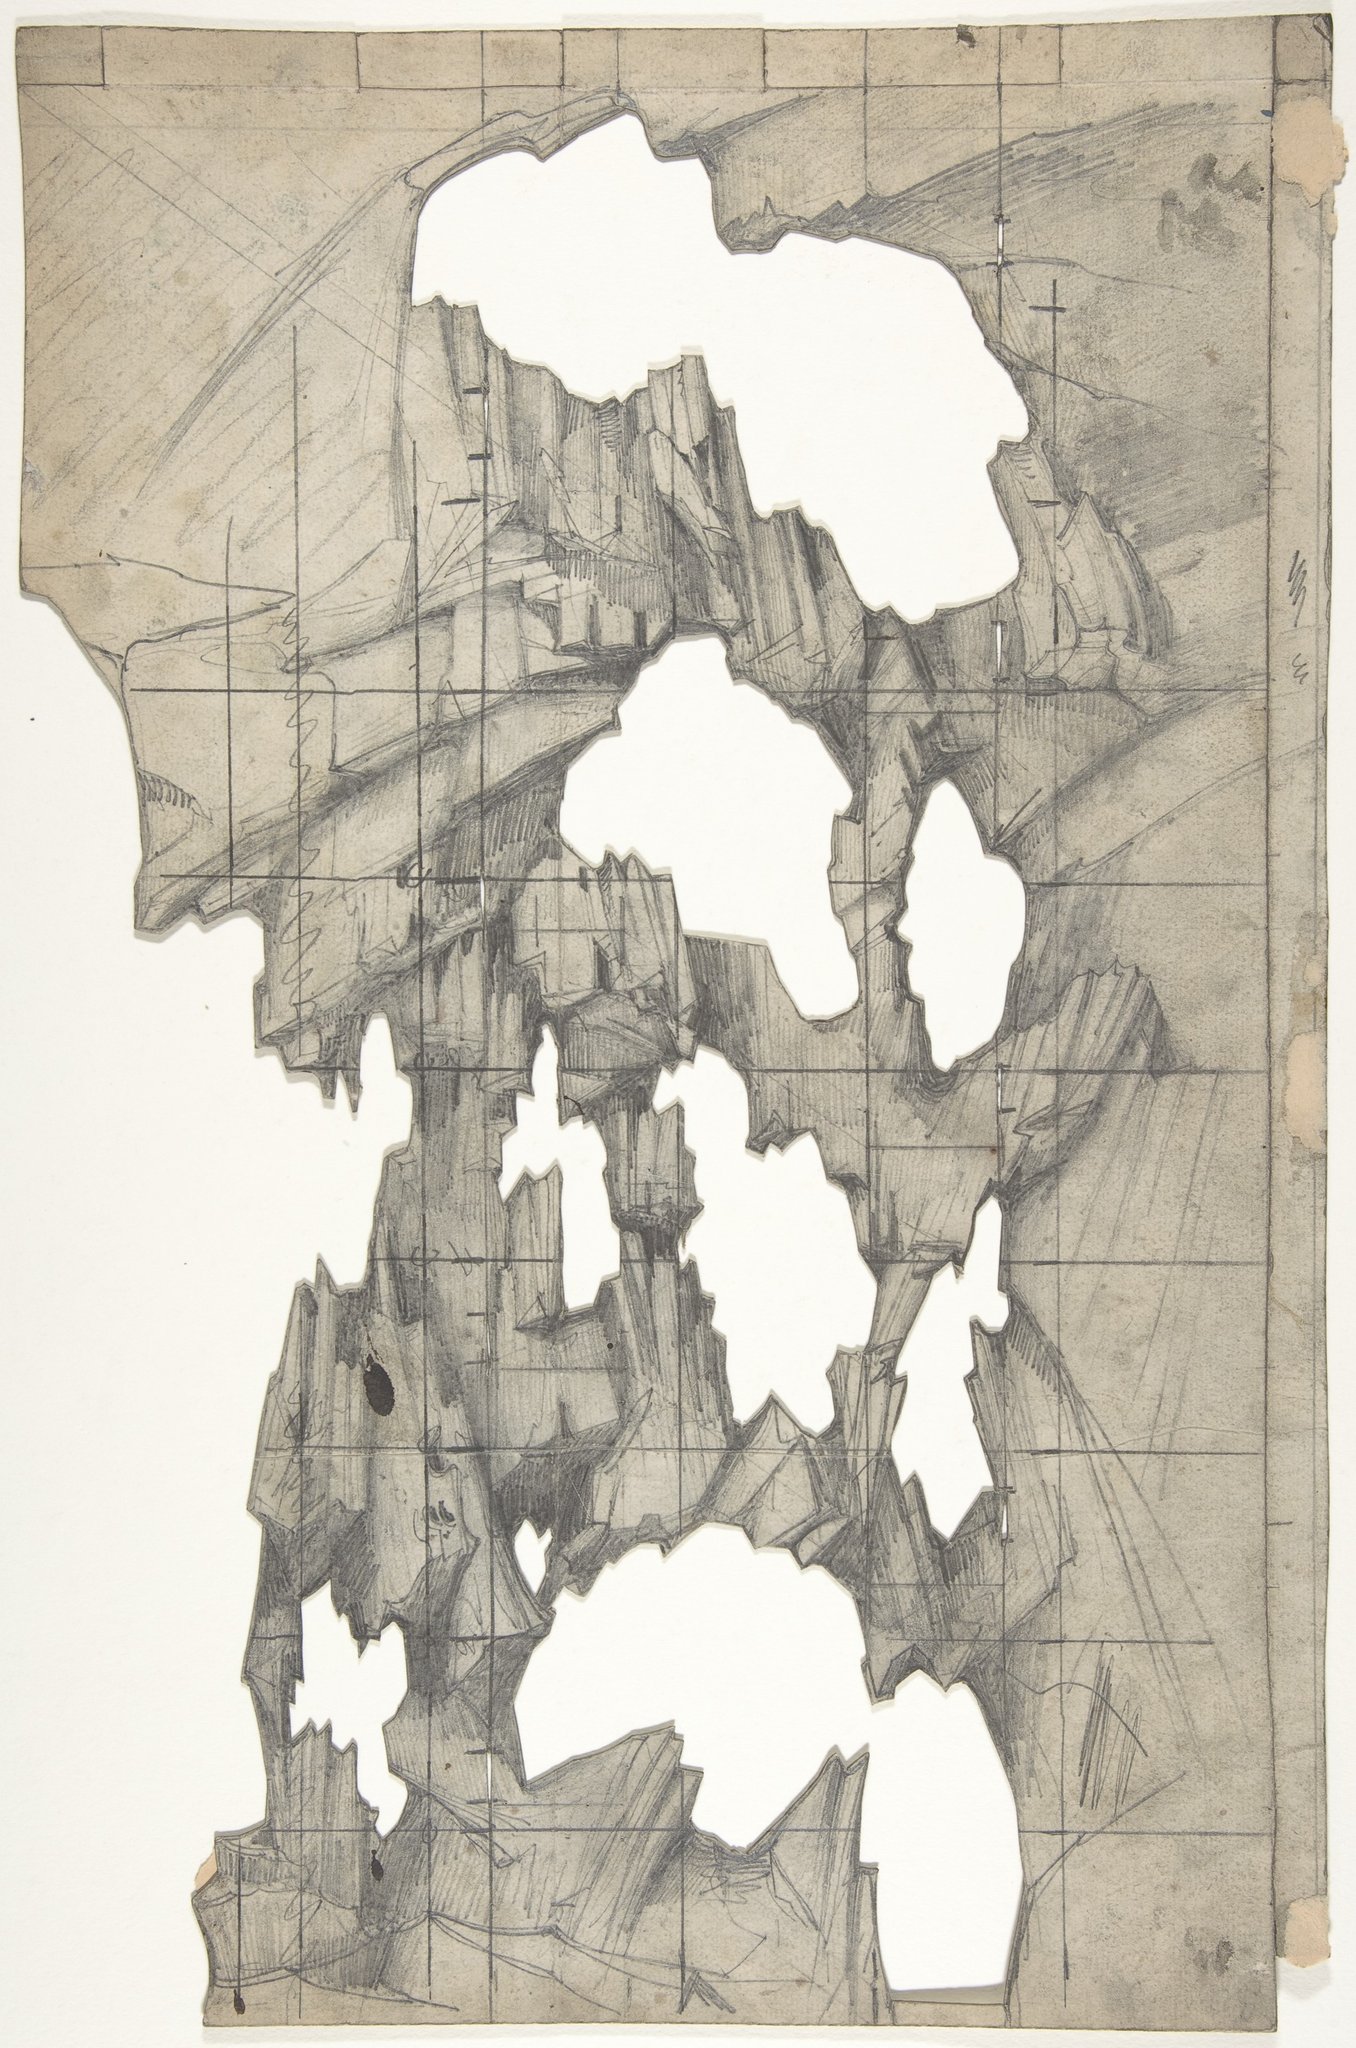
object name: drawing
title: Design for a Stage Set at the Opéra, Paris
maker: eugène cicéri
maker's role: artist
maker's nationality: french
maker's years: 1813-1890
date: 1830-1890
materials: graphite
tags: stage design